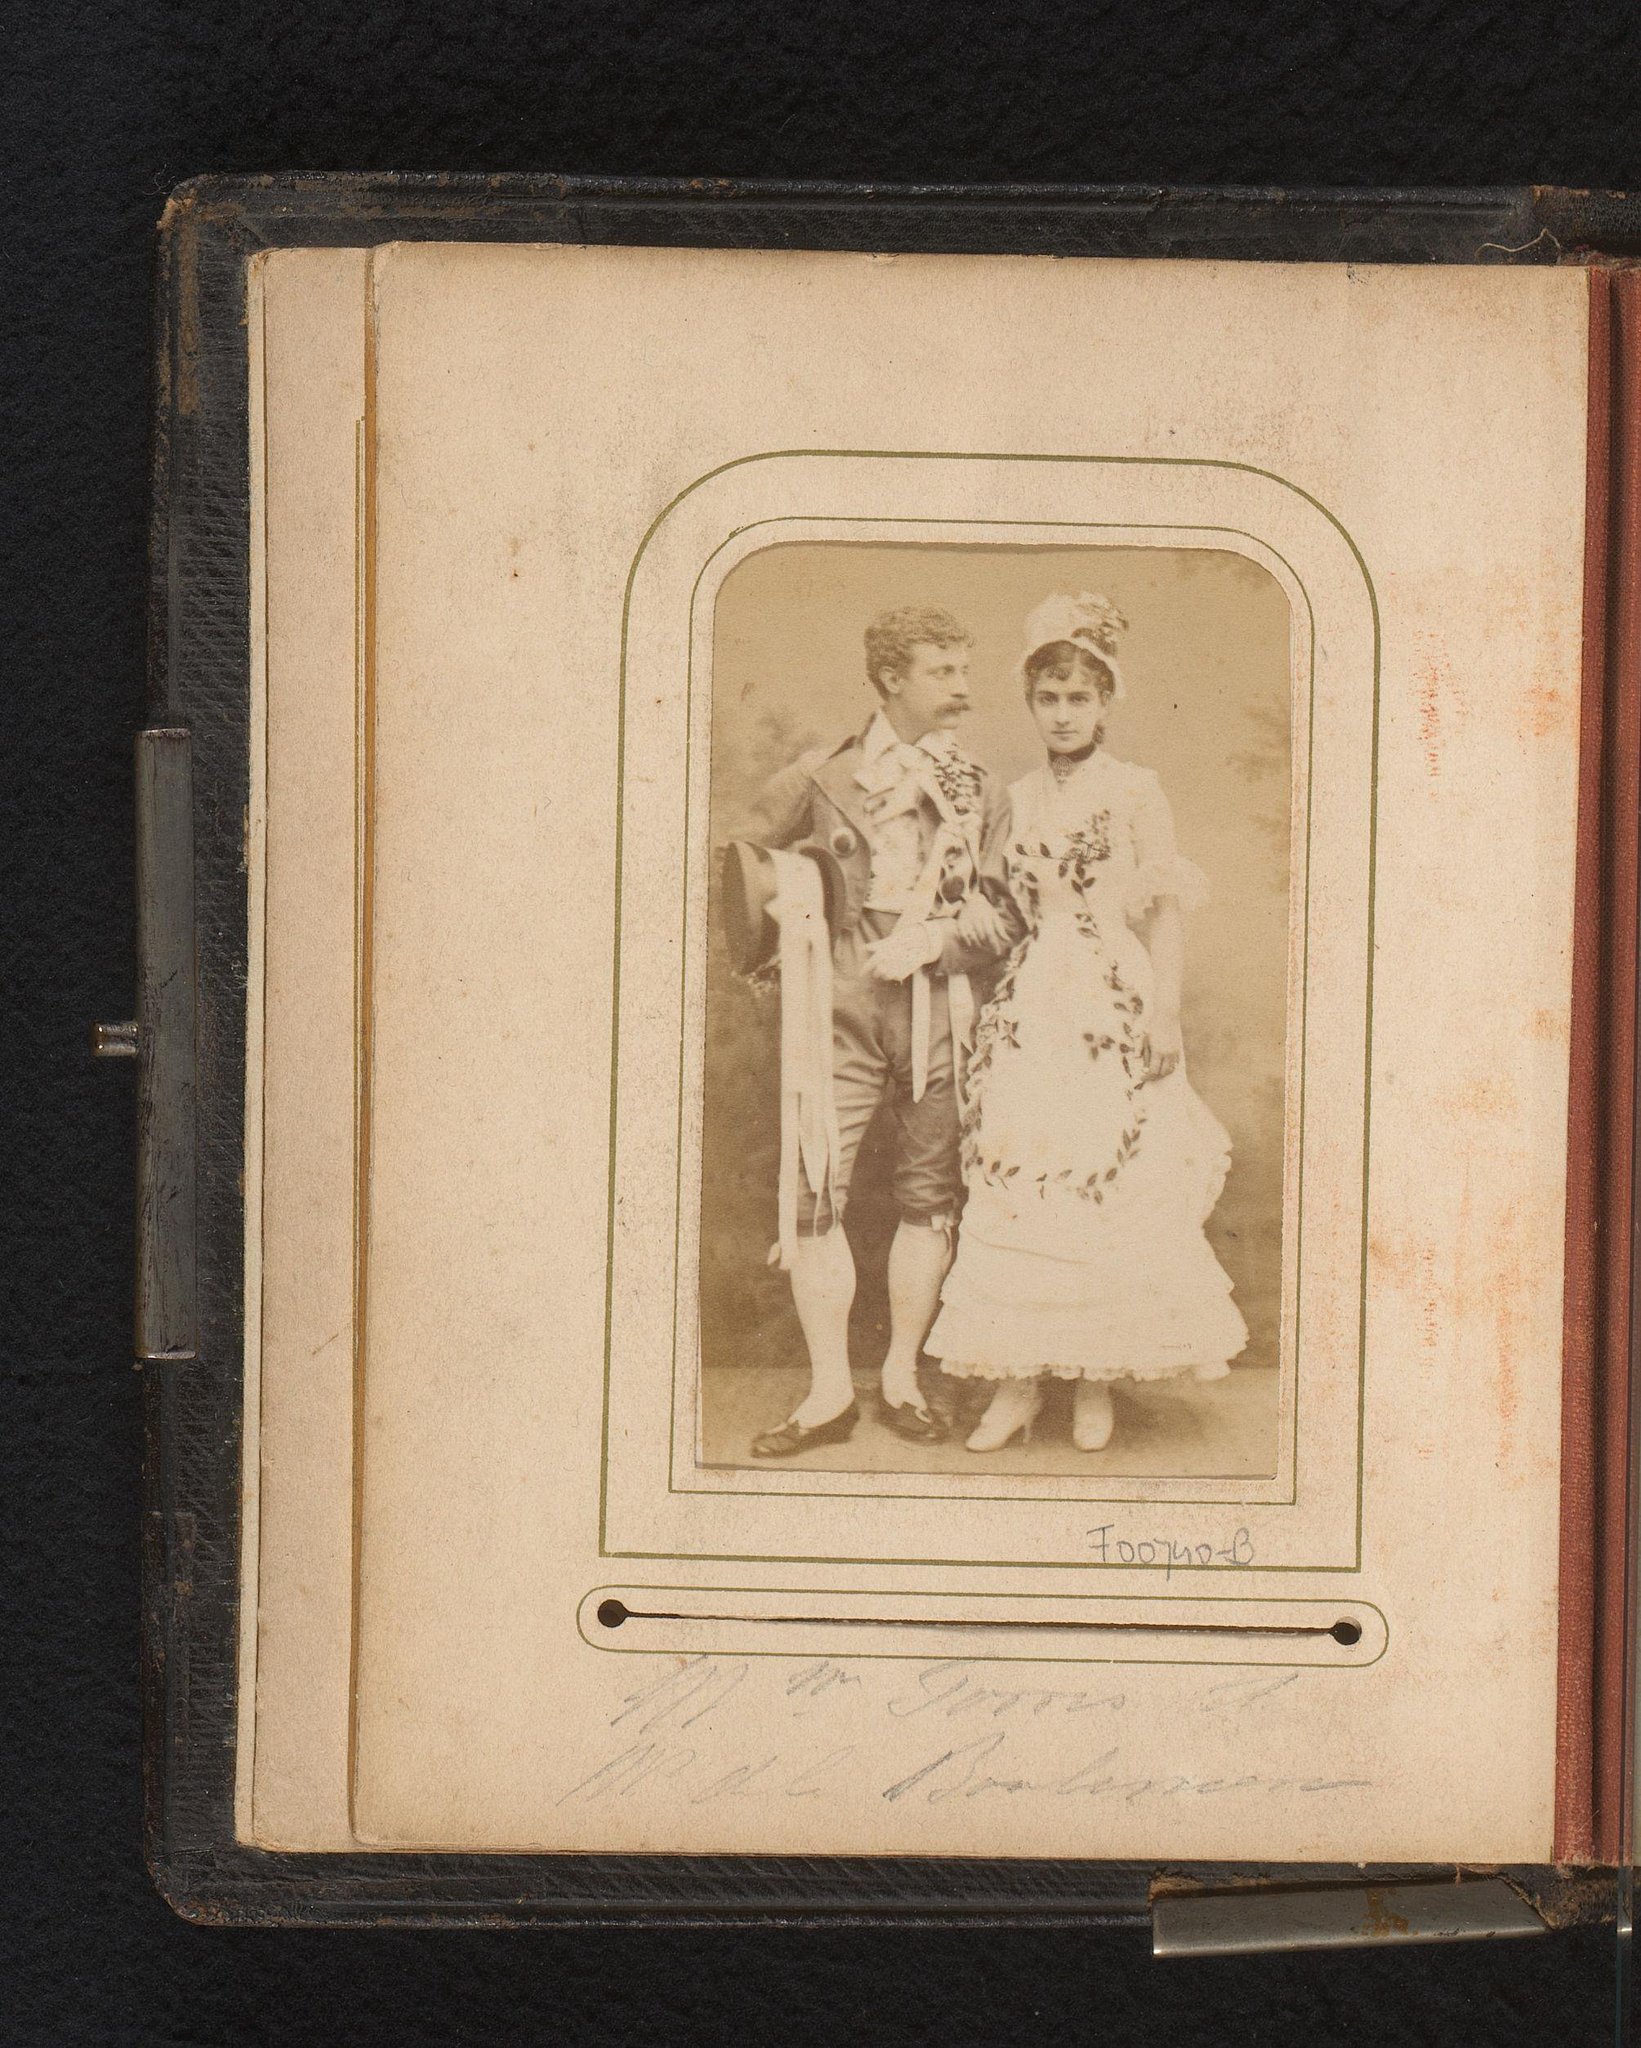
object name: photograph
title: Portret van een man en vrouw in kostuum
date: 1877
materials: cardboard, photographic support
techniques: albumen print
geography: the hague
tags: historical persons - bb - woman, historical persons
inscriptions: inscription: ‘De Lavieter & Co./ Photographes/ Willemstraat No2/ La Haye’, annotation: ‘[...]’